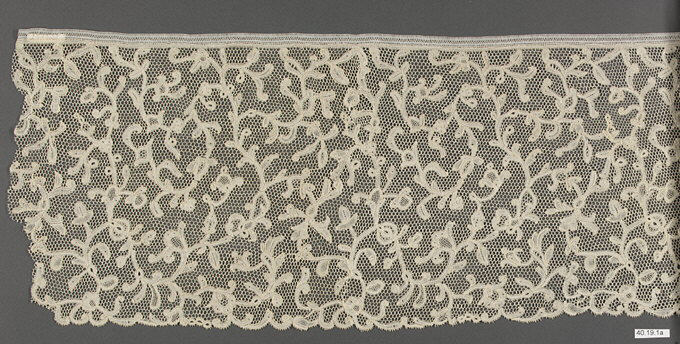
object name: border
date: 1801-1900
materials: lace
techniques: lace